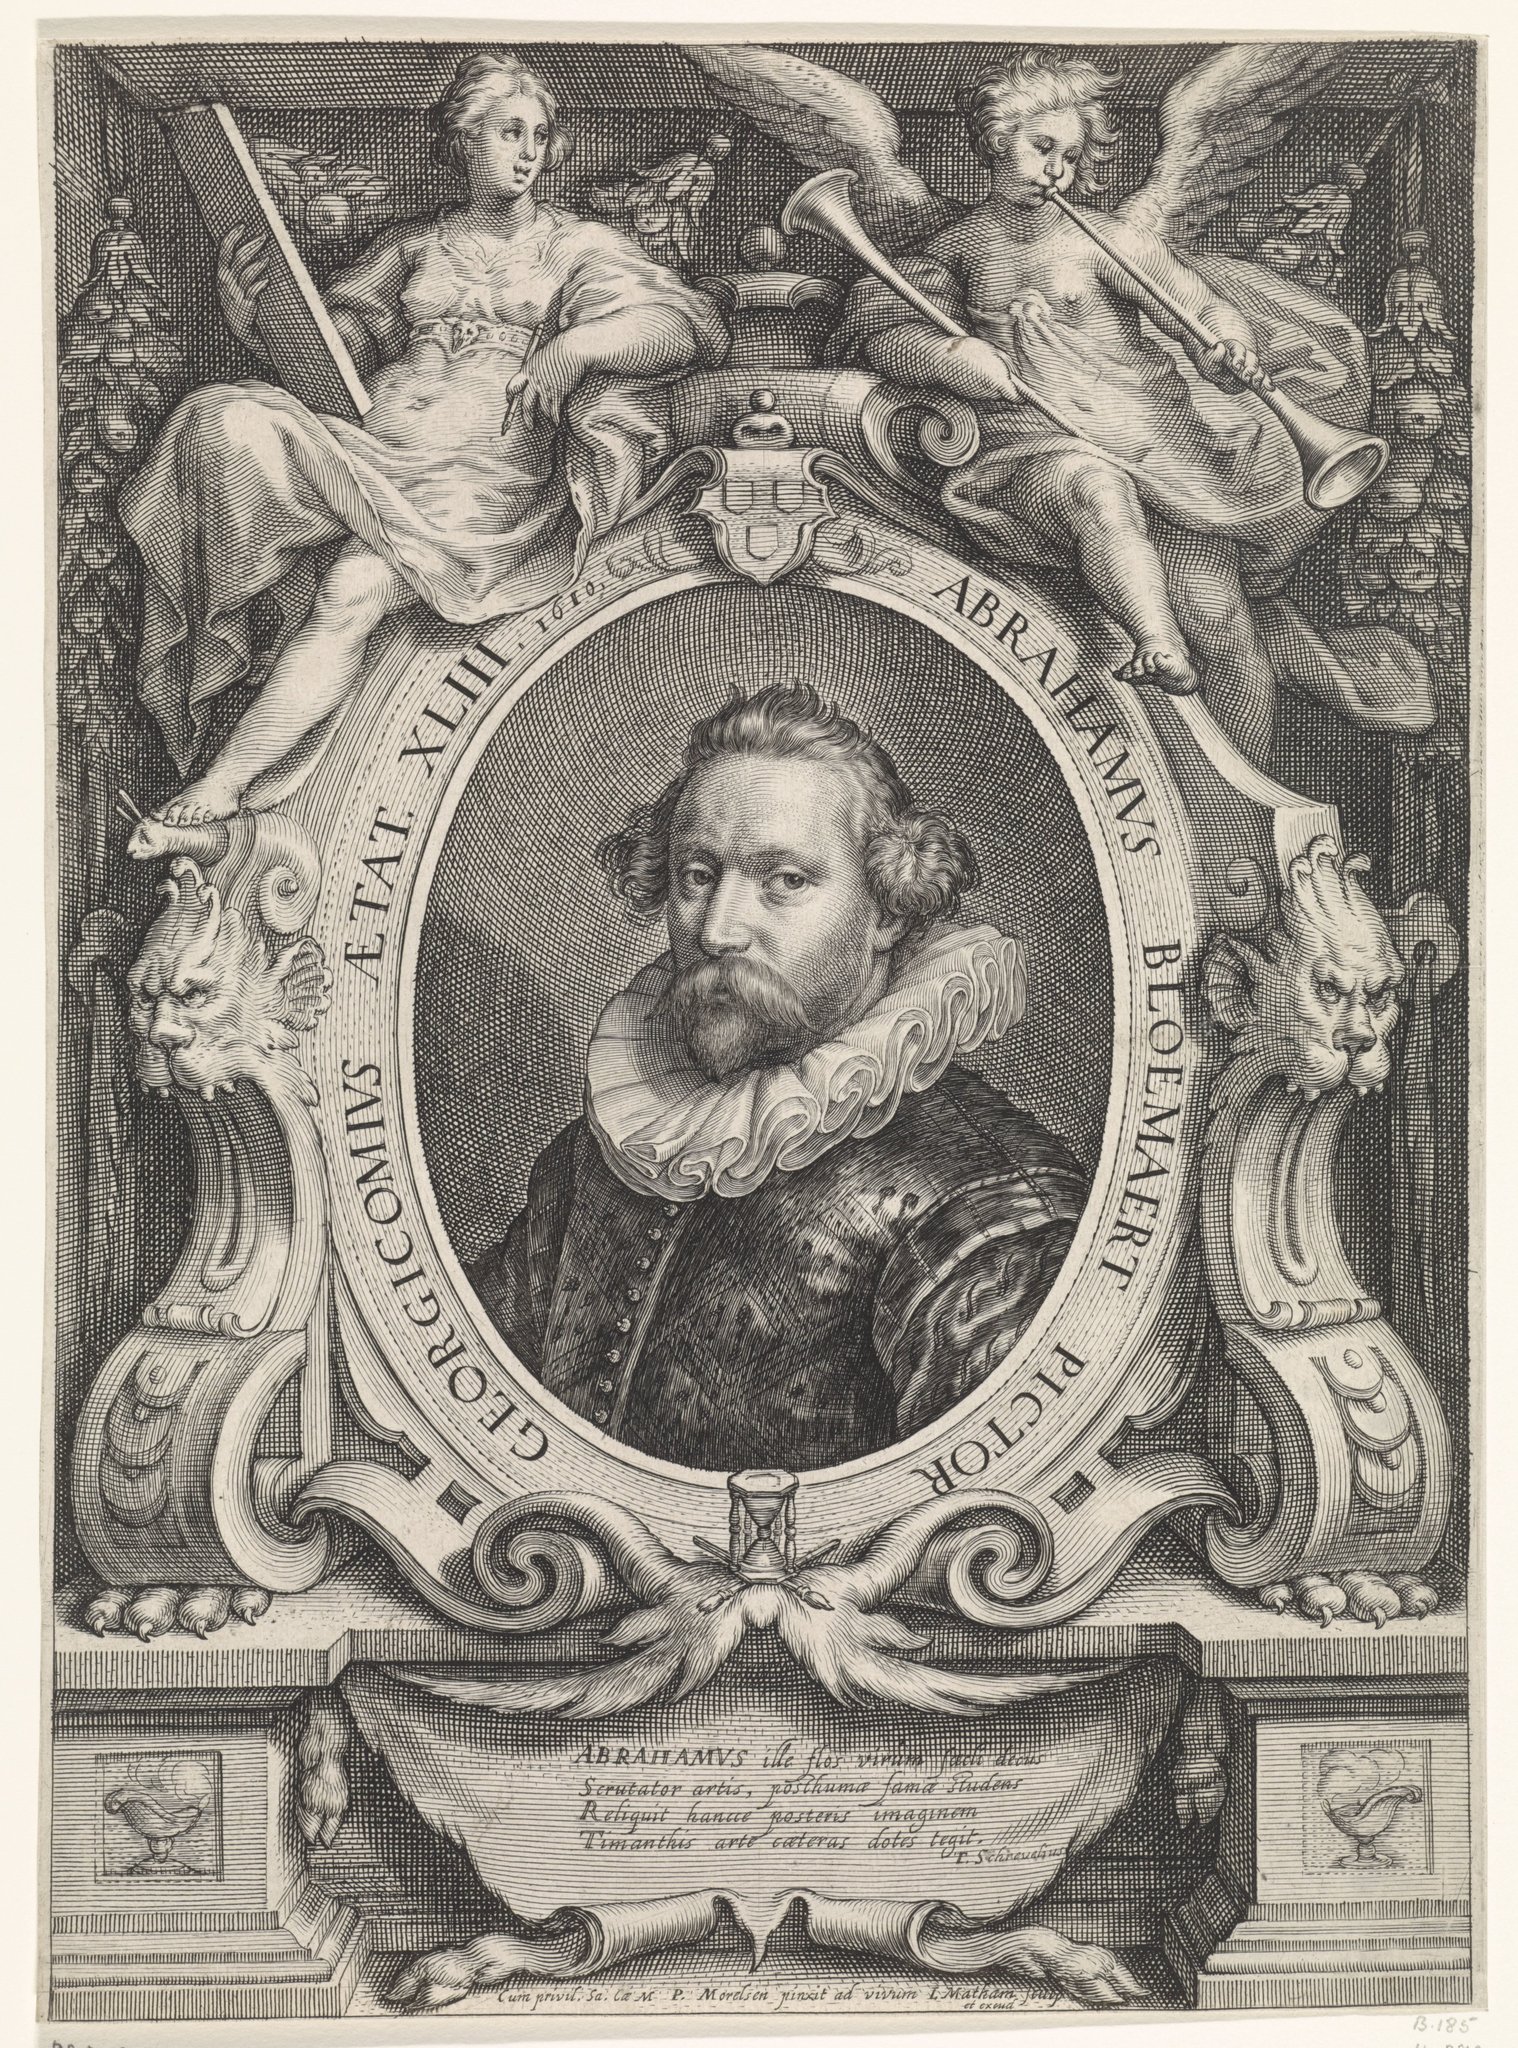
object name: print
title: Portret van Abraham Bloemaert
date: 1610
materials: paper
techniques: engraving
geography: haarlem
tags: utrecht, painter, print maker, draughtsman, abraham bloemaert, historical persons, portrait, self-portrait of painter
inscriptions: collector's mark: Lugt 240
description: Portret van de schilder Abraham Bloemaert, op 62-jarige leeftijd, met bovenaan de ovale omlijsting de personificaties van de tekenkunst (Disegno) en de faam (Fama).